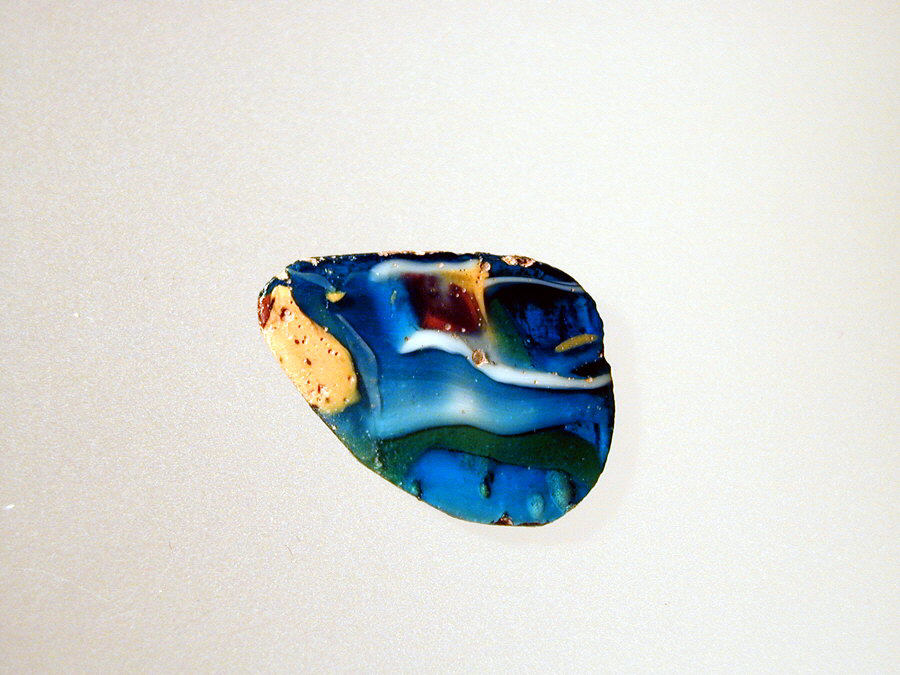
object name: fragment, mosaic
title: Glass mosaic fragment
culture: roman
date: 34 BCE-33 CE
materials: glass